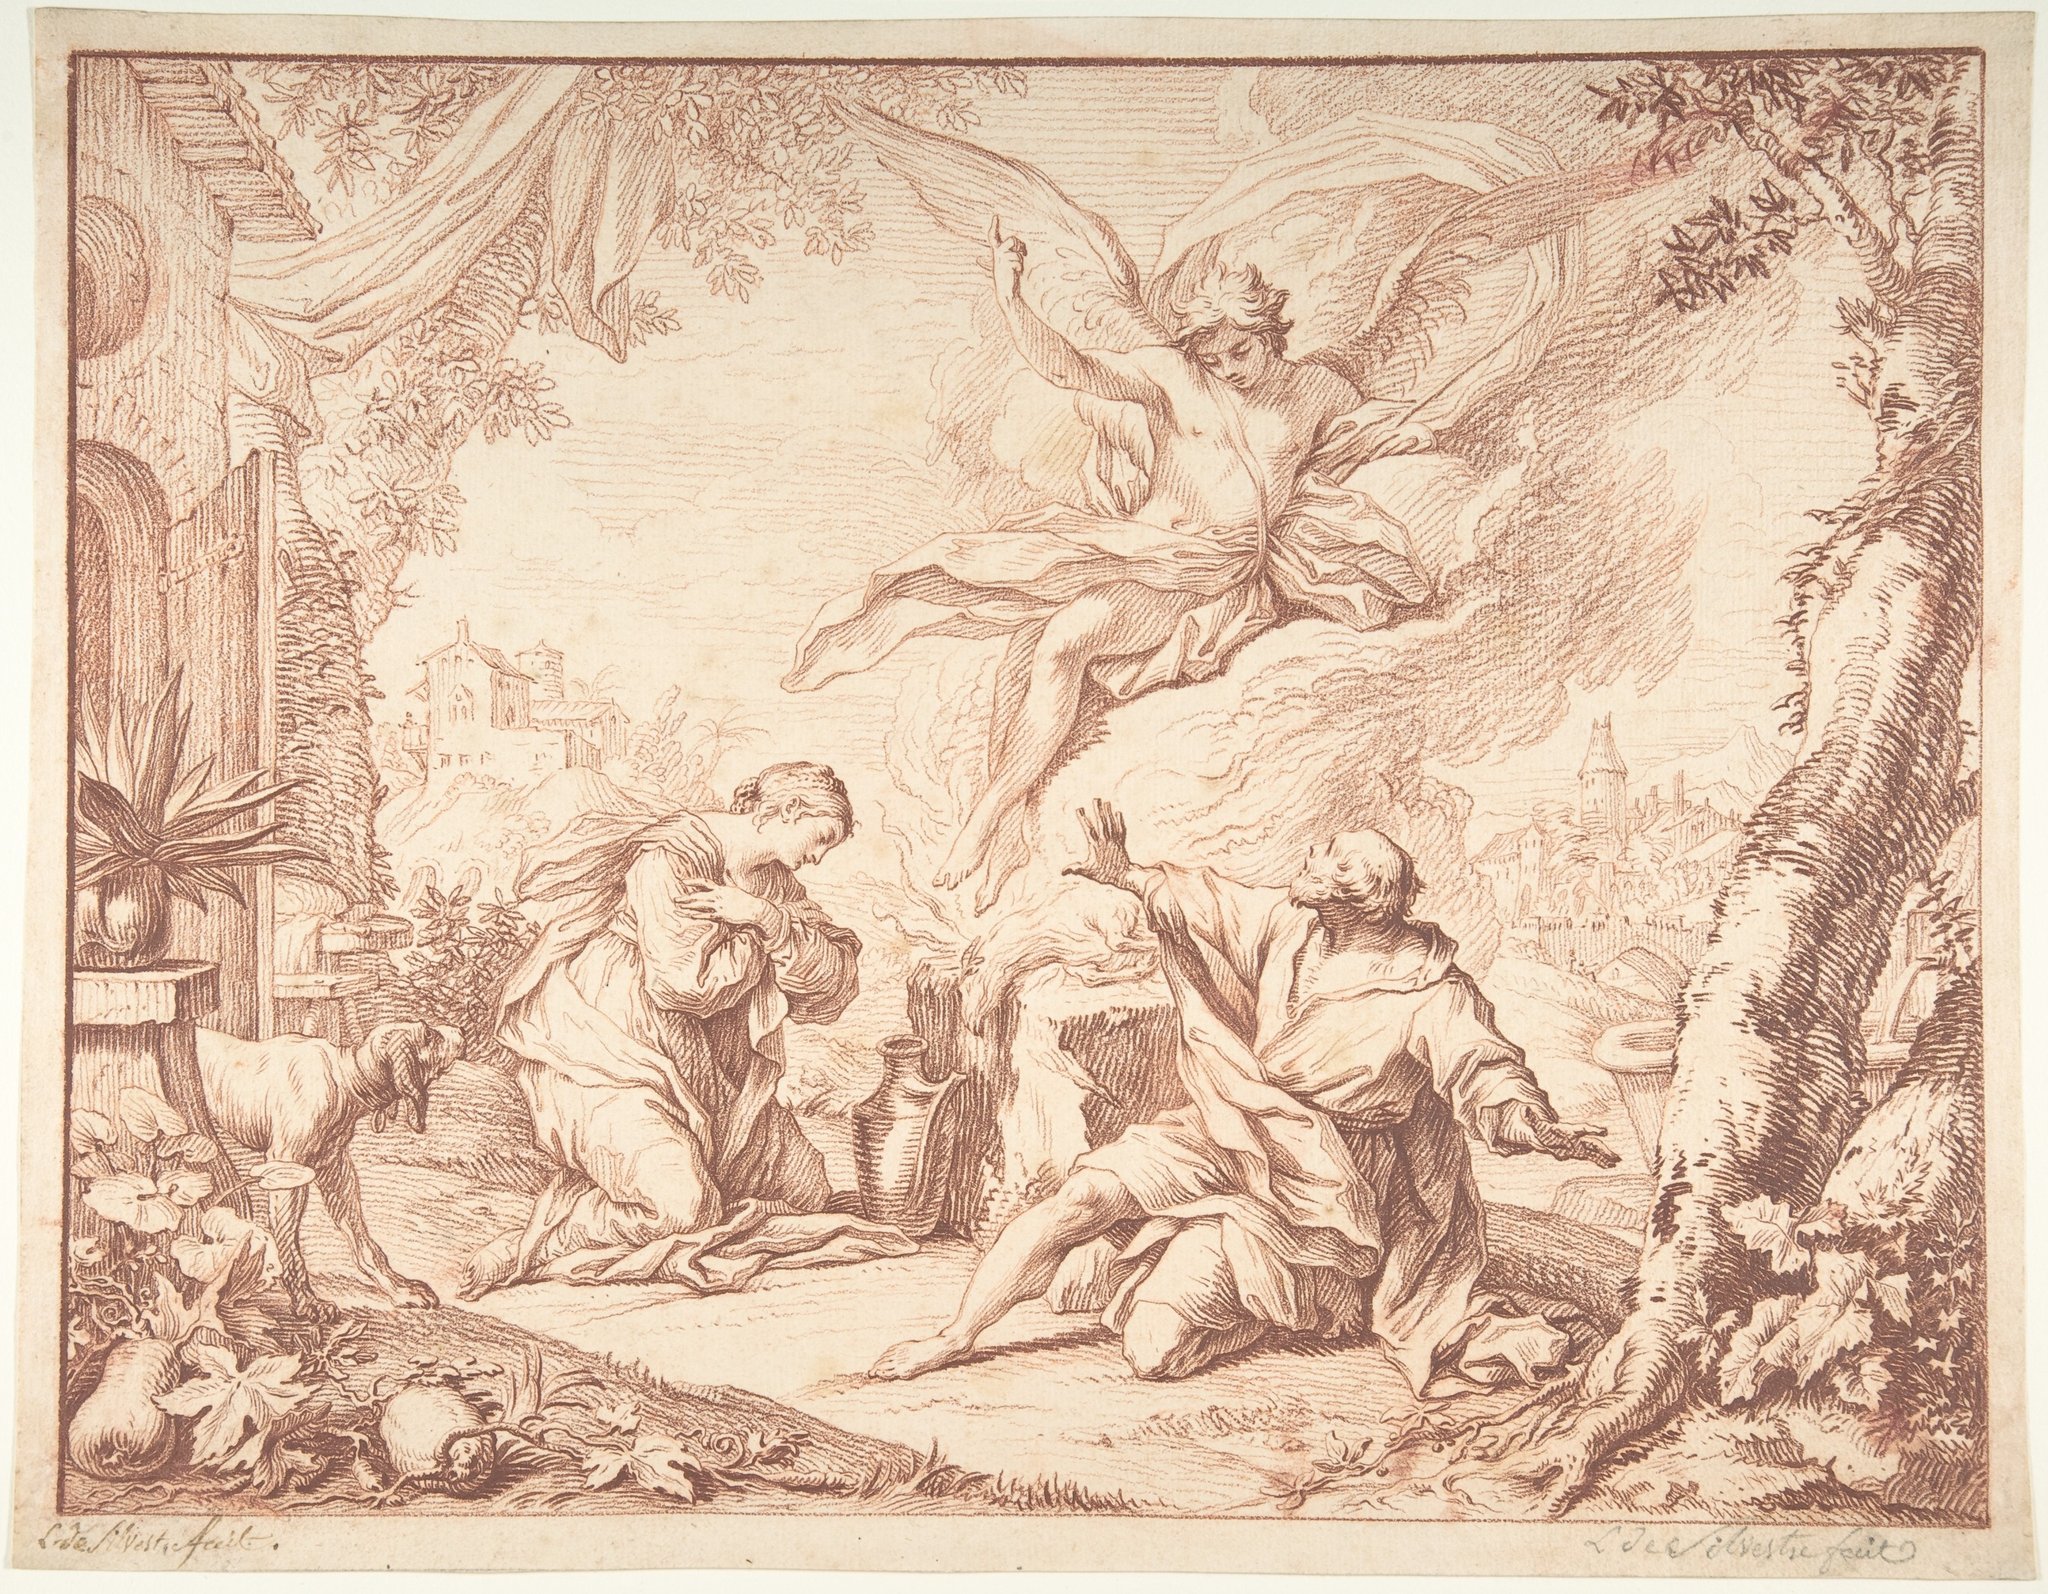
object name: drawing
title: The Sacrifice of Manoah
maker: jacques dumont, called le romain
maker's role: artist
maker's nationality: french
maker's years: 1701-1781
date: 1701-1800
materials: chalk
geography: france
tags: animals,men,women